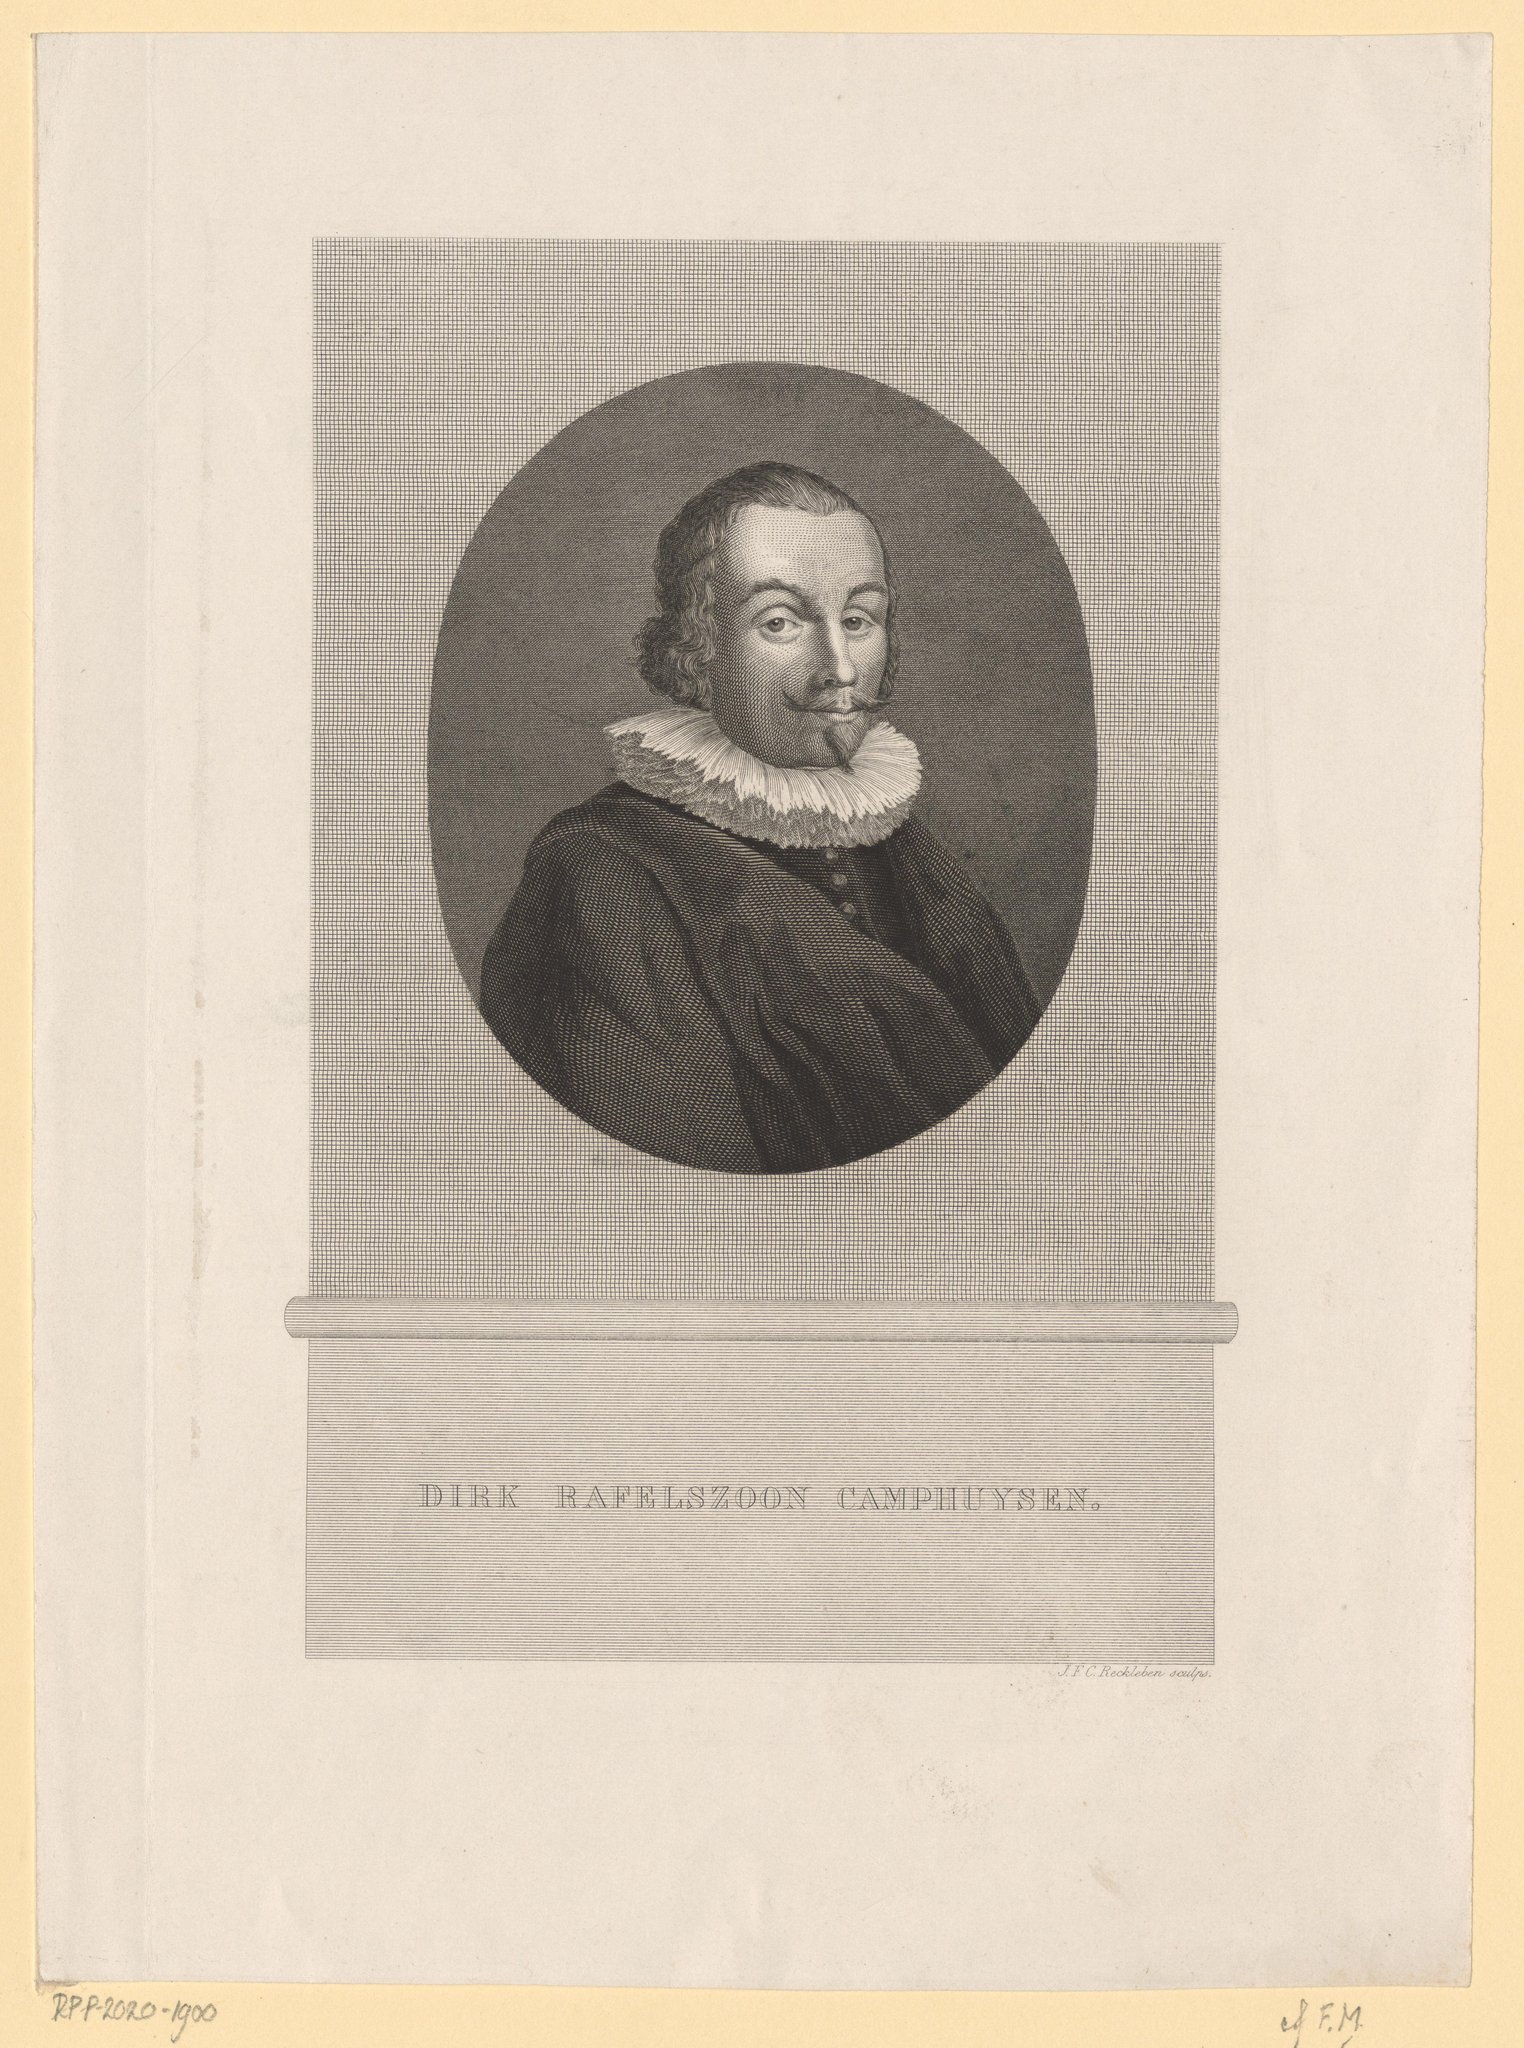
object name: print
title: Portret van Dirck Rafaelsz. Camphuysen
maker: jan frederik christiaan reckleben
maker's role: print maker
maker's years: 1819-1879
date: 1829-1879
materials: paper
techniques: engraving, etching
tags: historical persons